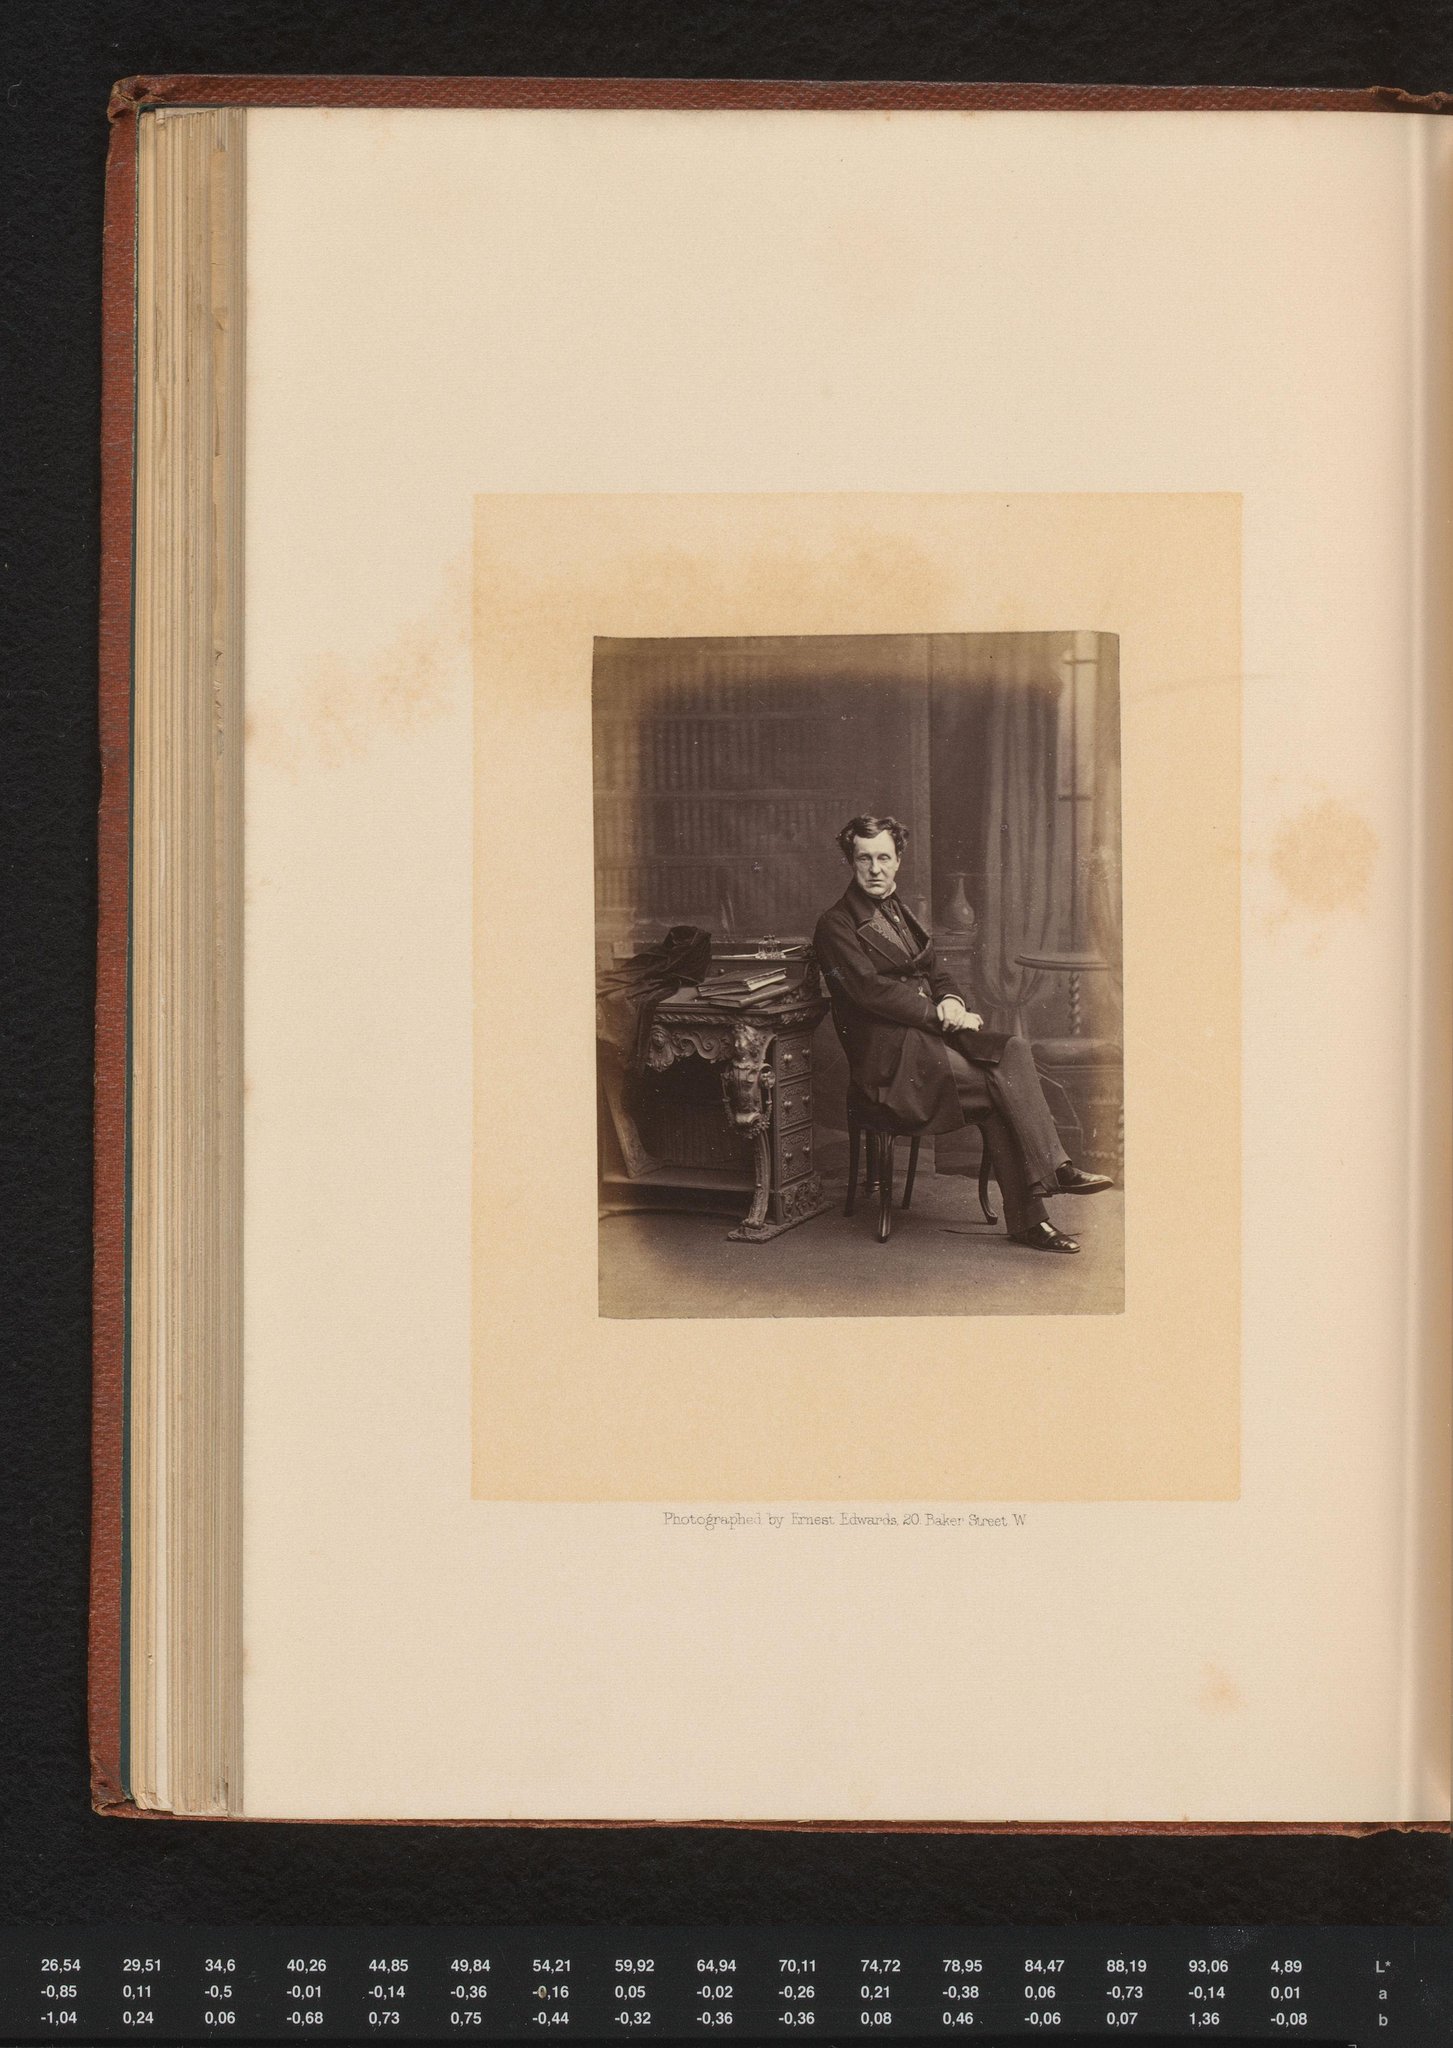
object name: page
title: Portret van de politicus James Emerson Tennent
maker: ernest edwards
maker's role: fotograaf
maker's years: 1837-1903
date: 1862-1867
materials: paper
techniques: albumen print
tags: adult man, historical persons, politician, e.g. party leader